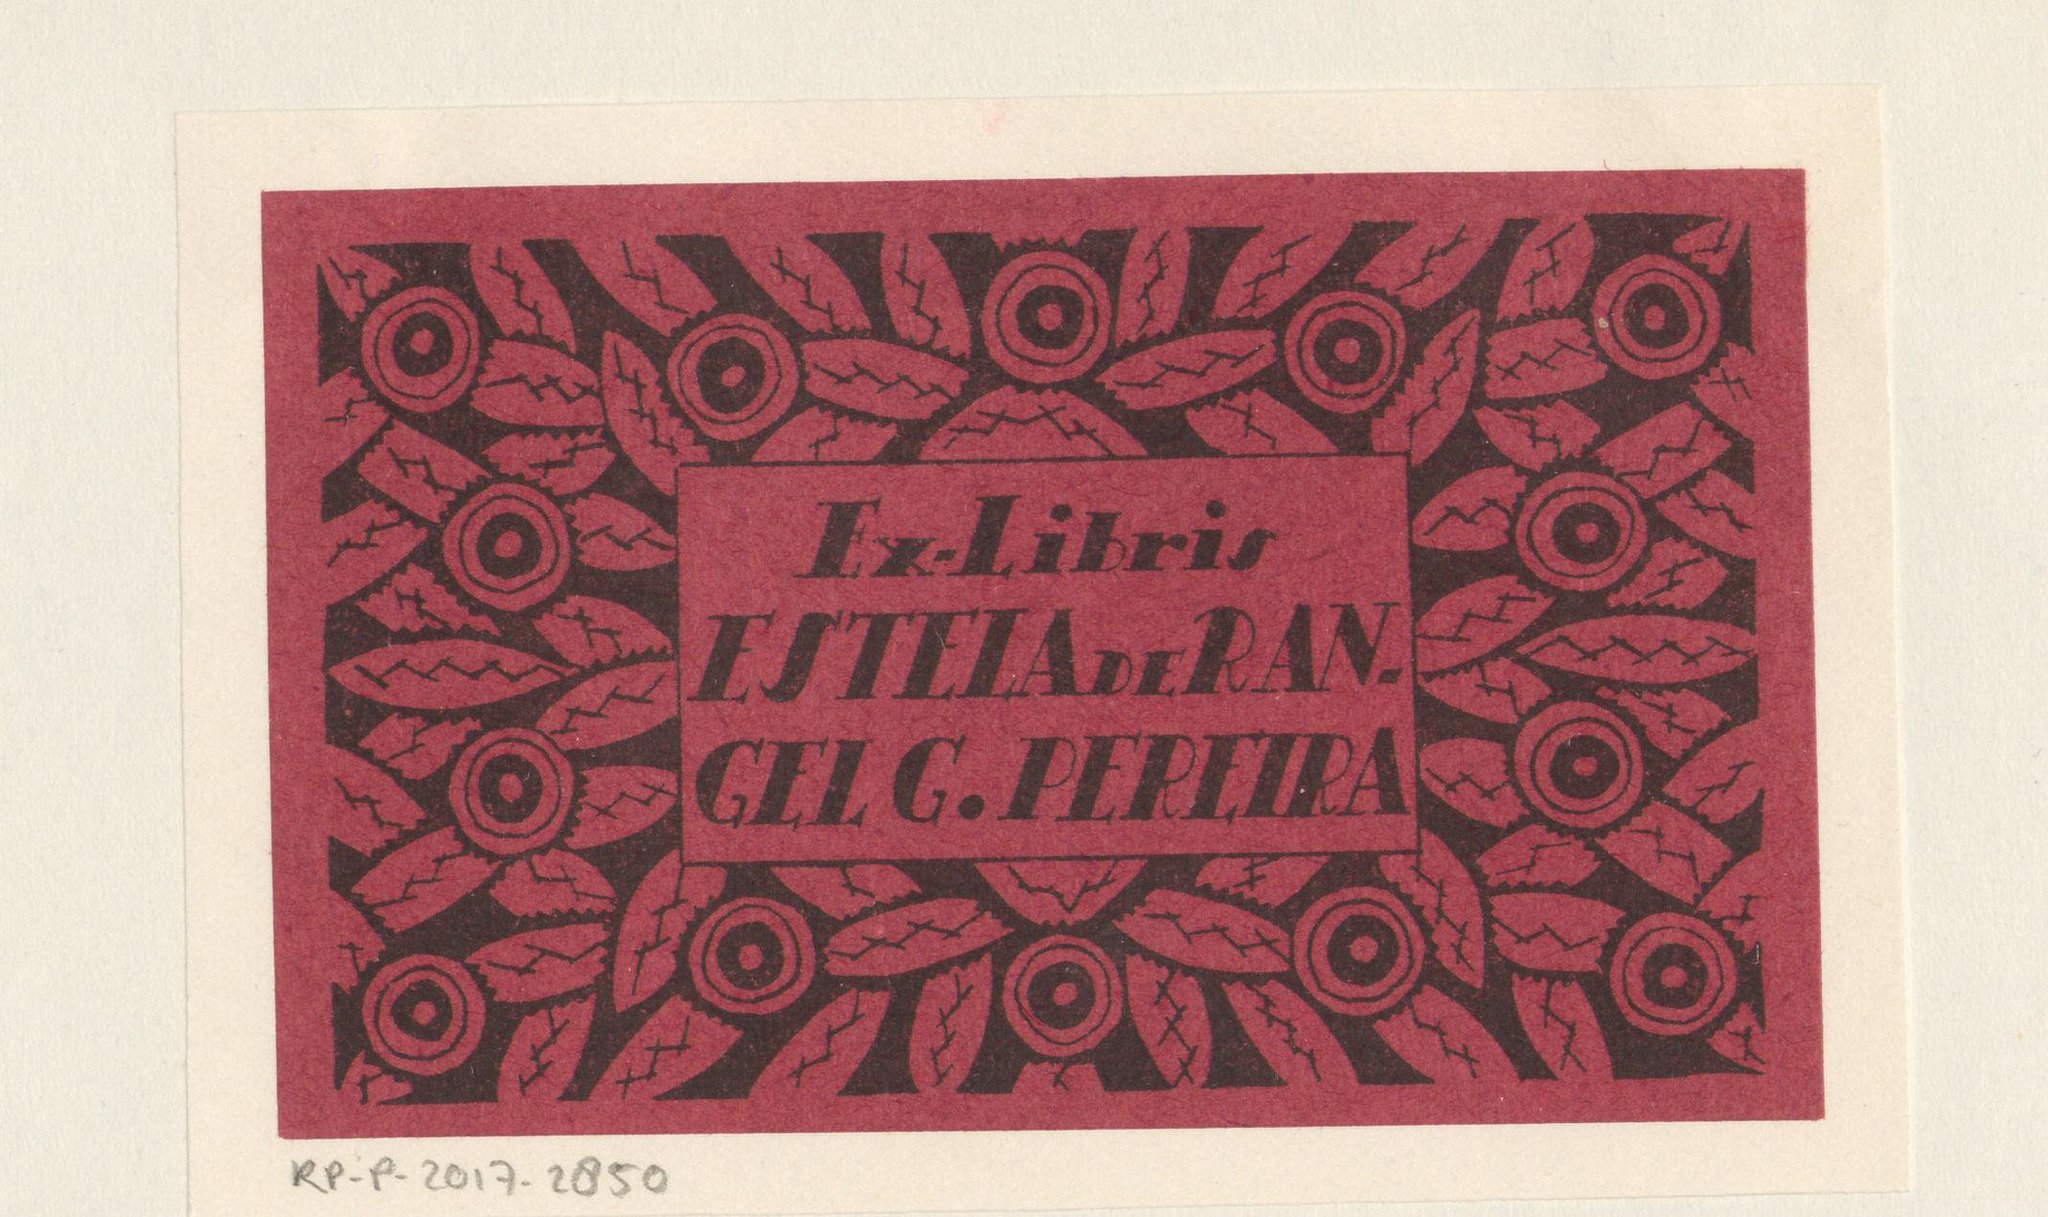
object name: bookplate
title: Ex libris van Estela de Rangel G. Pereira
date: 1900-1999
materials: paper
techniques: printing block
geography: portugal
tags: foliage ~ ornament - aa - stylized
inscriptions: workshop stamp: ‘7 / ipse fecit’